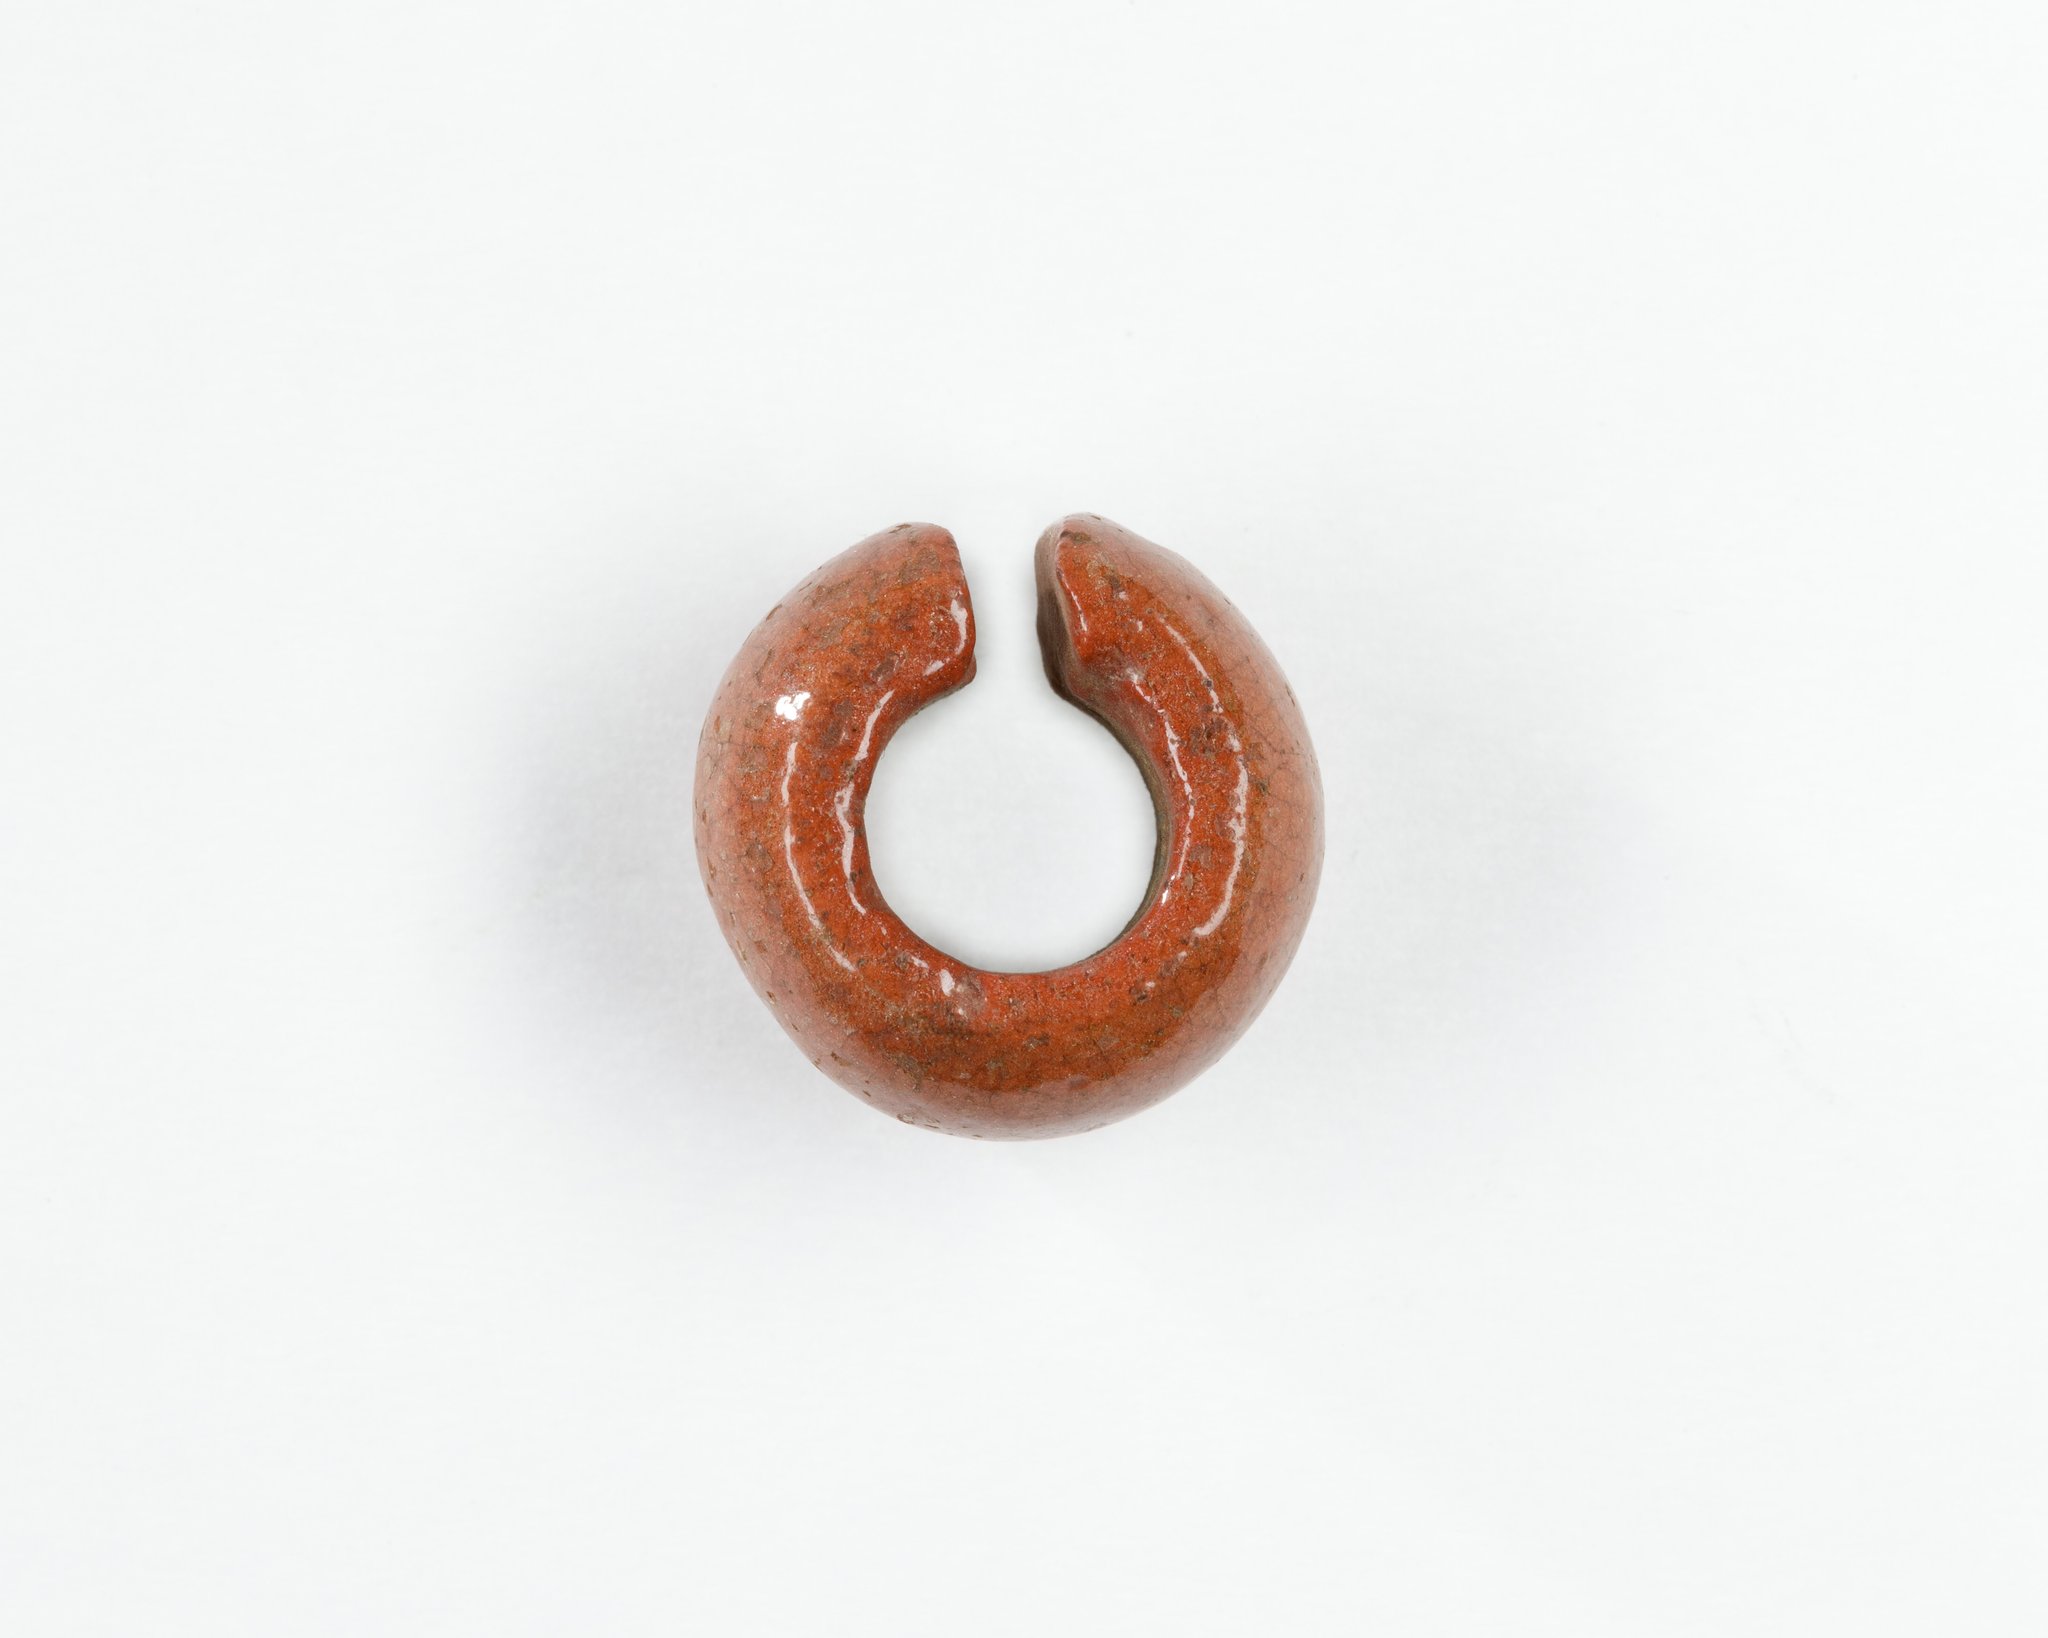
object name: earring, penannular, circular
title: Penannular Earring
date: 1550-1295 BCE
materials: faience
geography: northern upper egypt